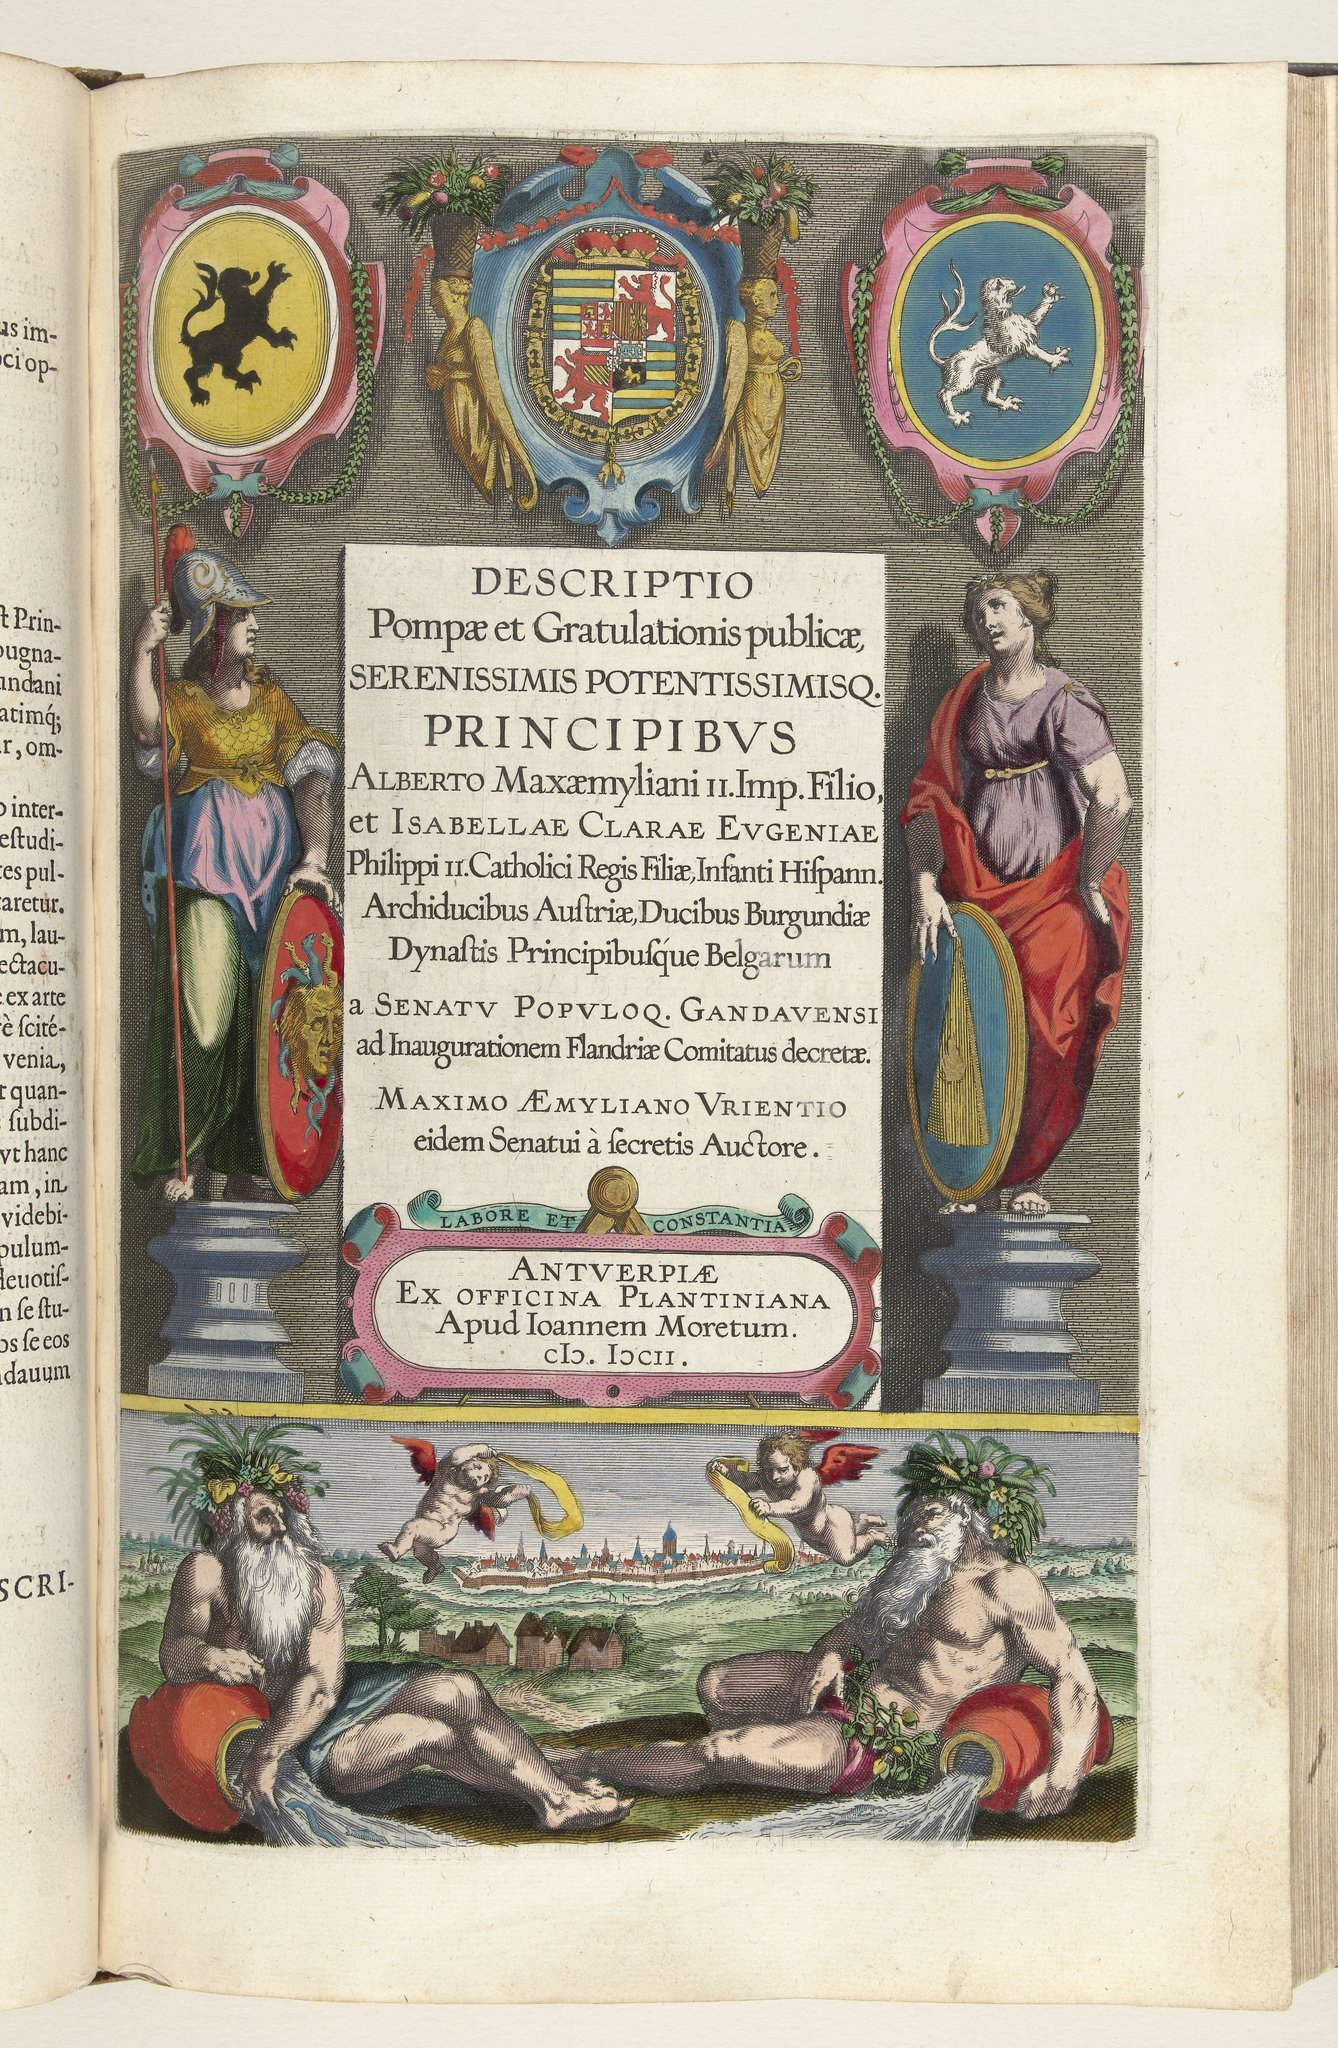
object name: print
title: Titelprent voor de beschrijving van de intocht van Albrecht en Isabella in Gent, 1599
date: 1600-1602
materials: paper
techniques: engraving, hand coloring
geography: antwerp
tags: title-page, ghent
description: Titelprent voor Descriptio Pompae et Gratulationis publicae van M.A. Vrientius, waarin de beschrijving van de intocht van Albrecht en Isabella in Gent, december 1599. Titelprent met de Latijnse titel in een omlijsting met staande aan weerszijden op voetstukken Minerva en een vrouwelijke personificatie. Bovenaan drie wapens, onderaan een landschap met twee riviergoden. Onderdeel van: Historica narratio profectionis et inaugurationis serenissimorum Belgii principum Alberti et Isabellae Austriae archiducum, de beschrijving van de intochten van het paar te Brussel, Antwerpen, Gent en Valenciennes, 1599.